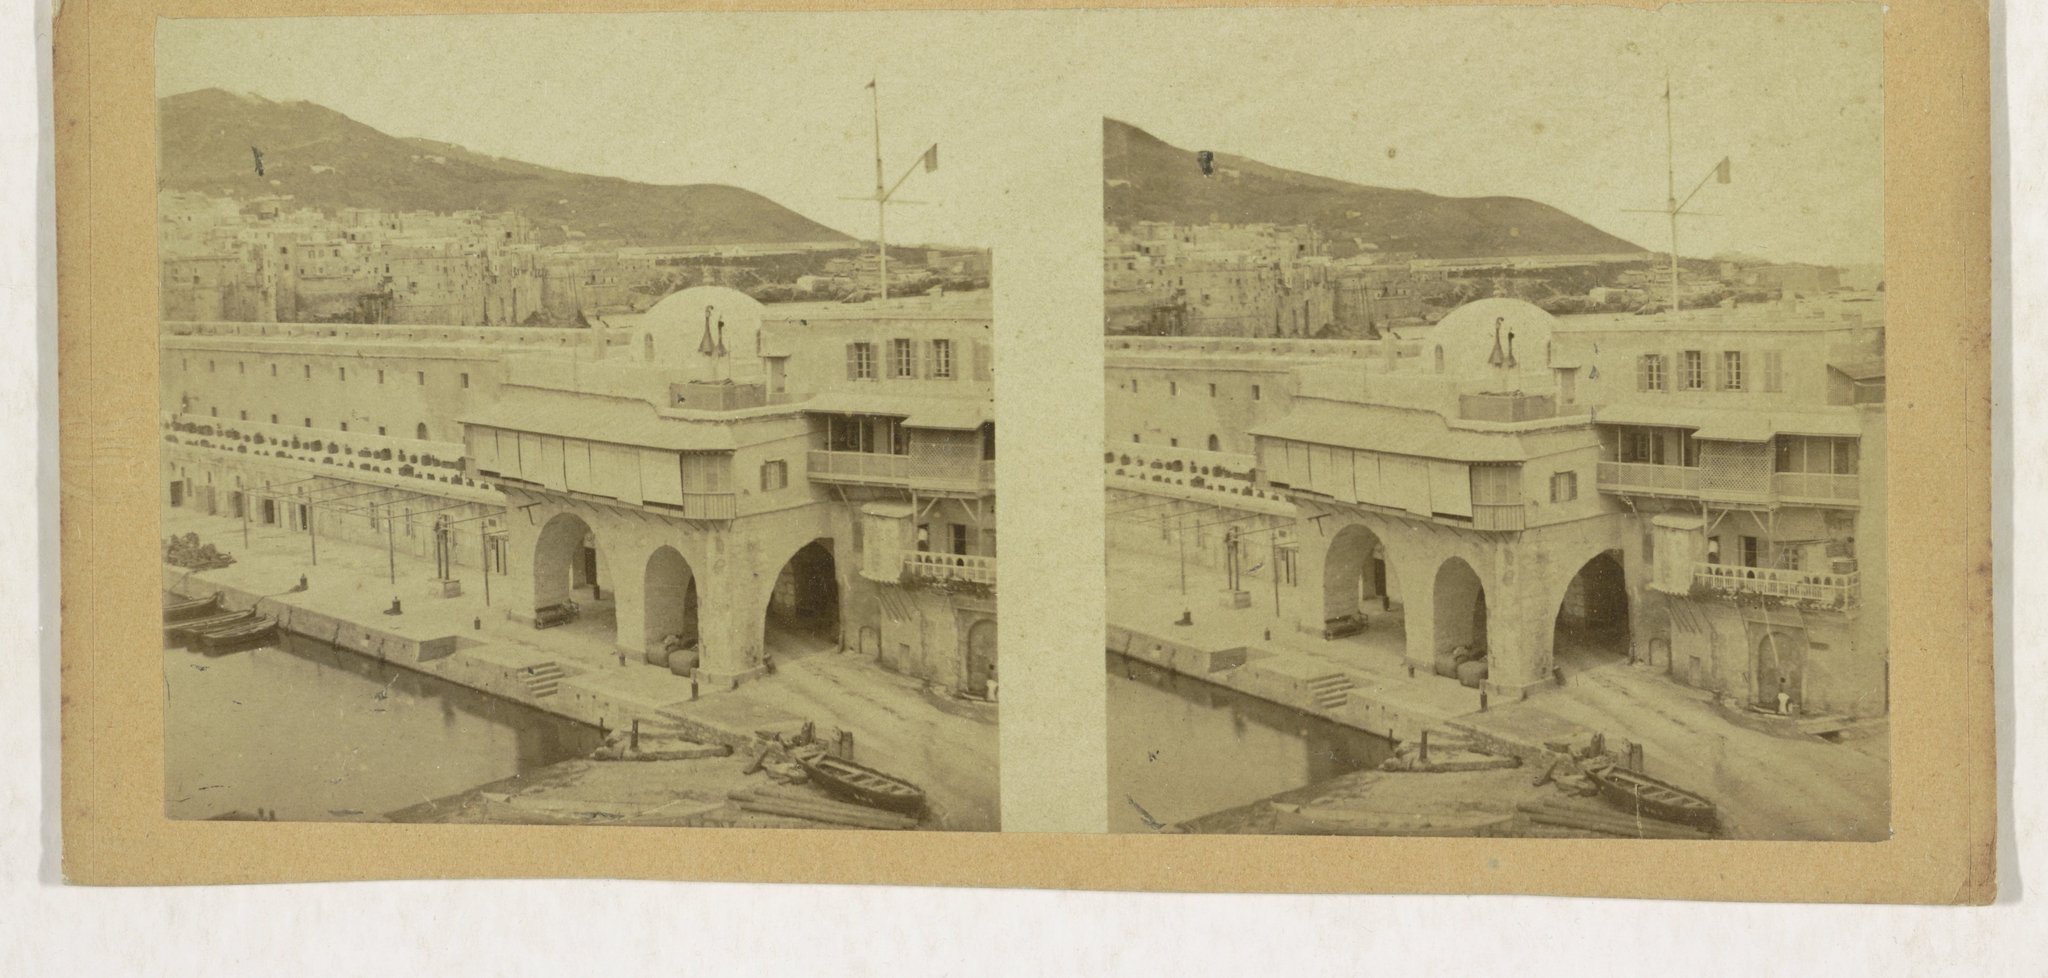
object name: stereograph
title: Admiraliteit in de haven van Algiers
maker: Anonymous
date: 1857-1863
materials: cardboard, paper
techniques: albumen print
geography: algiers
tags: harbour, commander-in-chief, admiral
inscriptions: monogram: ‘LM’, inscription: ‘A 11’